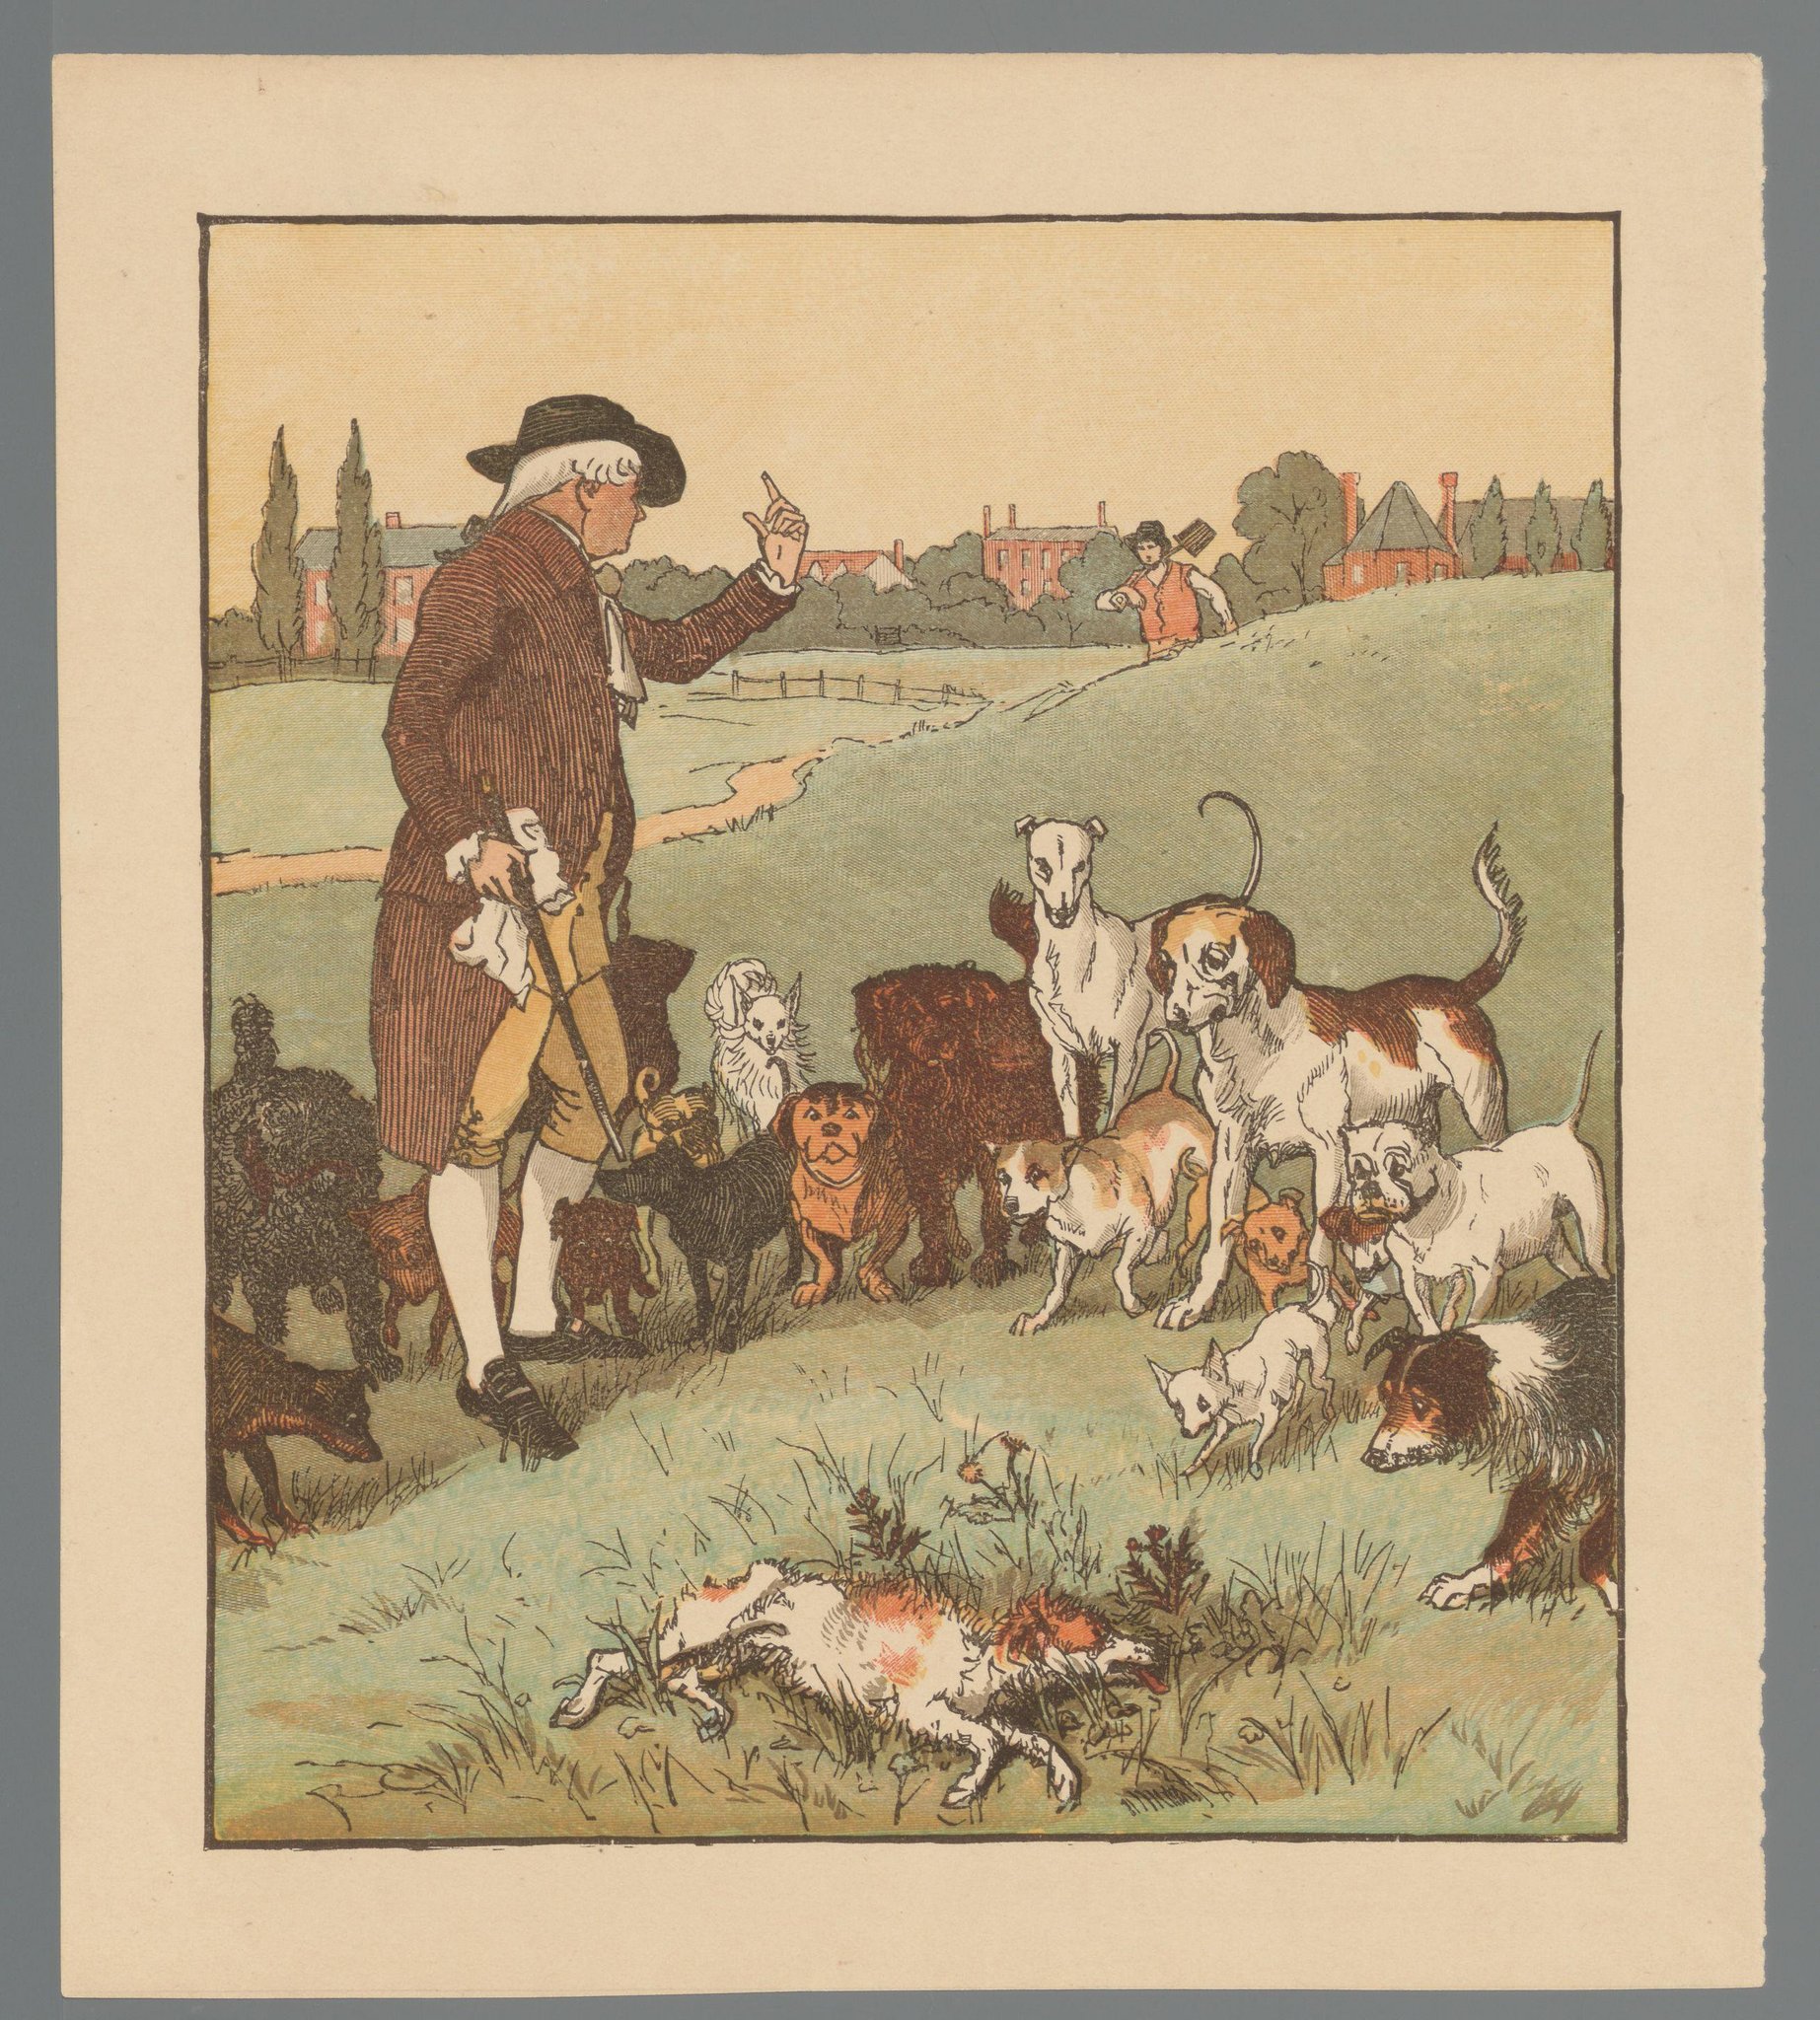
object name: print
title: Man en honden in een cirkel rondom een dode hond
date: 1879-1927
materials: paper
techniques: wood engraving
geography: london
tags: adult man, landscapes (+ landscape with figures, staffage), dog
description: Prent uit: Goldsmith, Oliver. Elegy on a mad dog. Londen: George Routledge & Sons, 1879. Of uit een later gepubliceerde uitgave waarin vier verhalen (waaronder 'Elegy on a mad dog') zijn gebundeld.